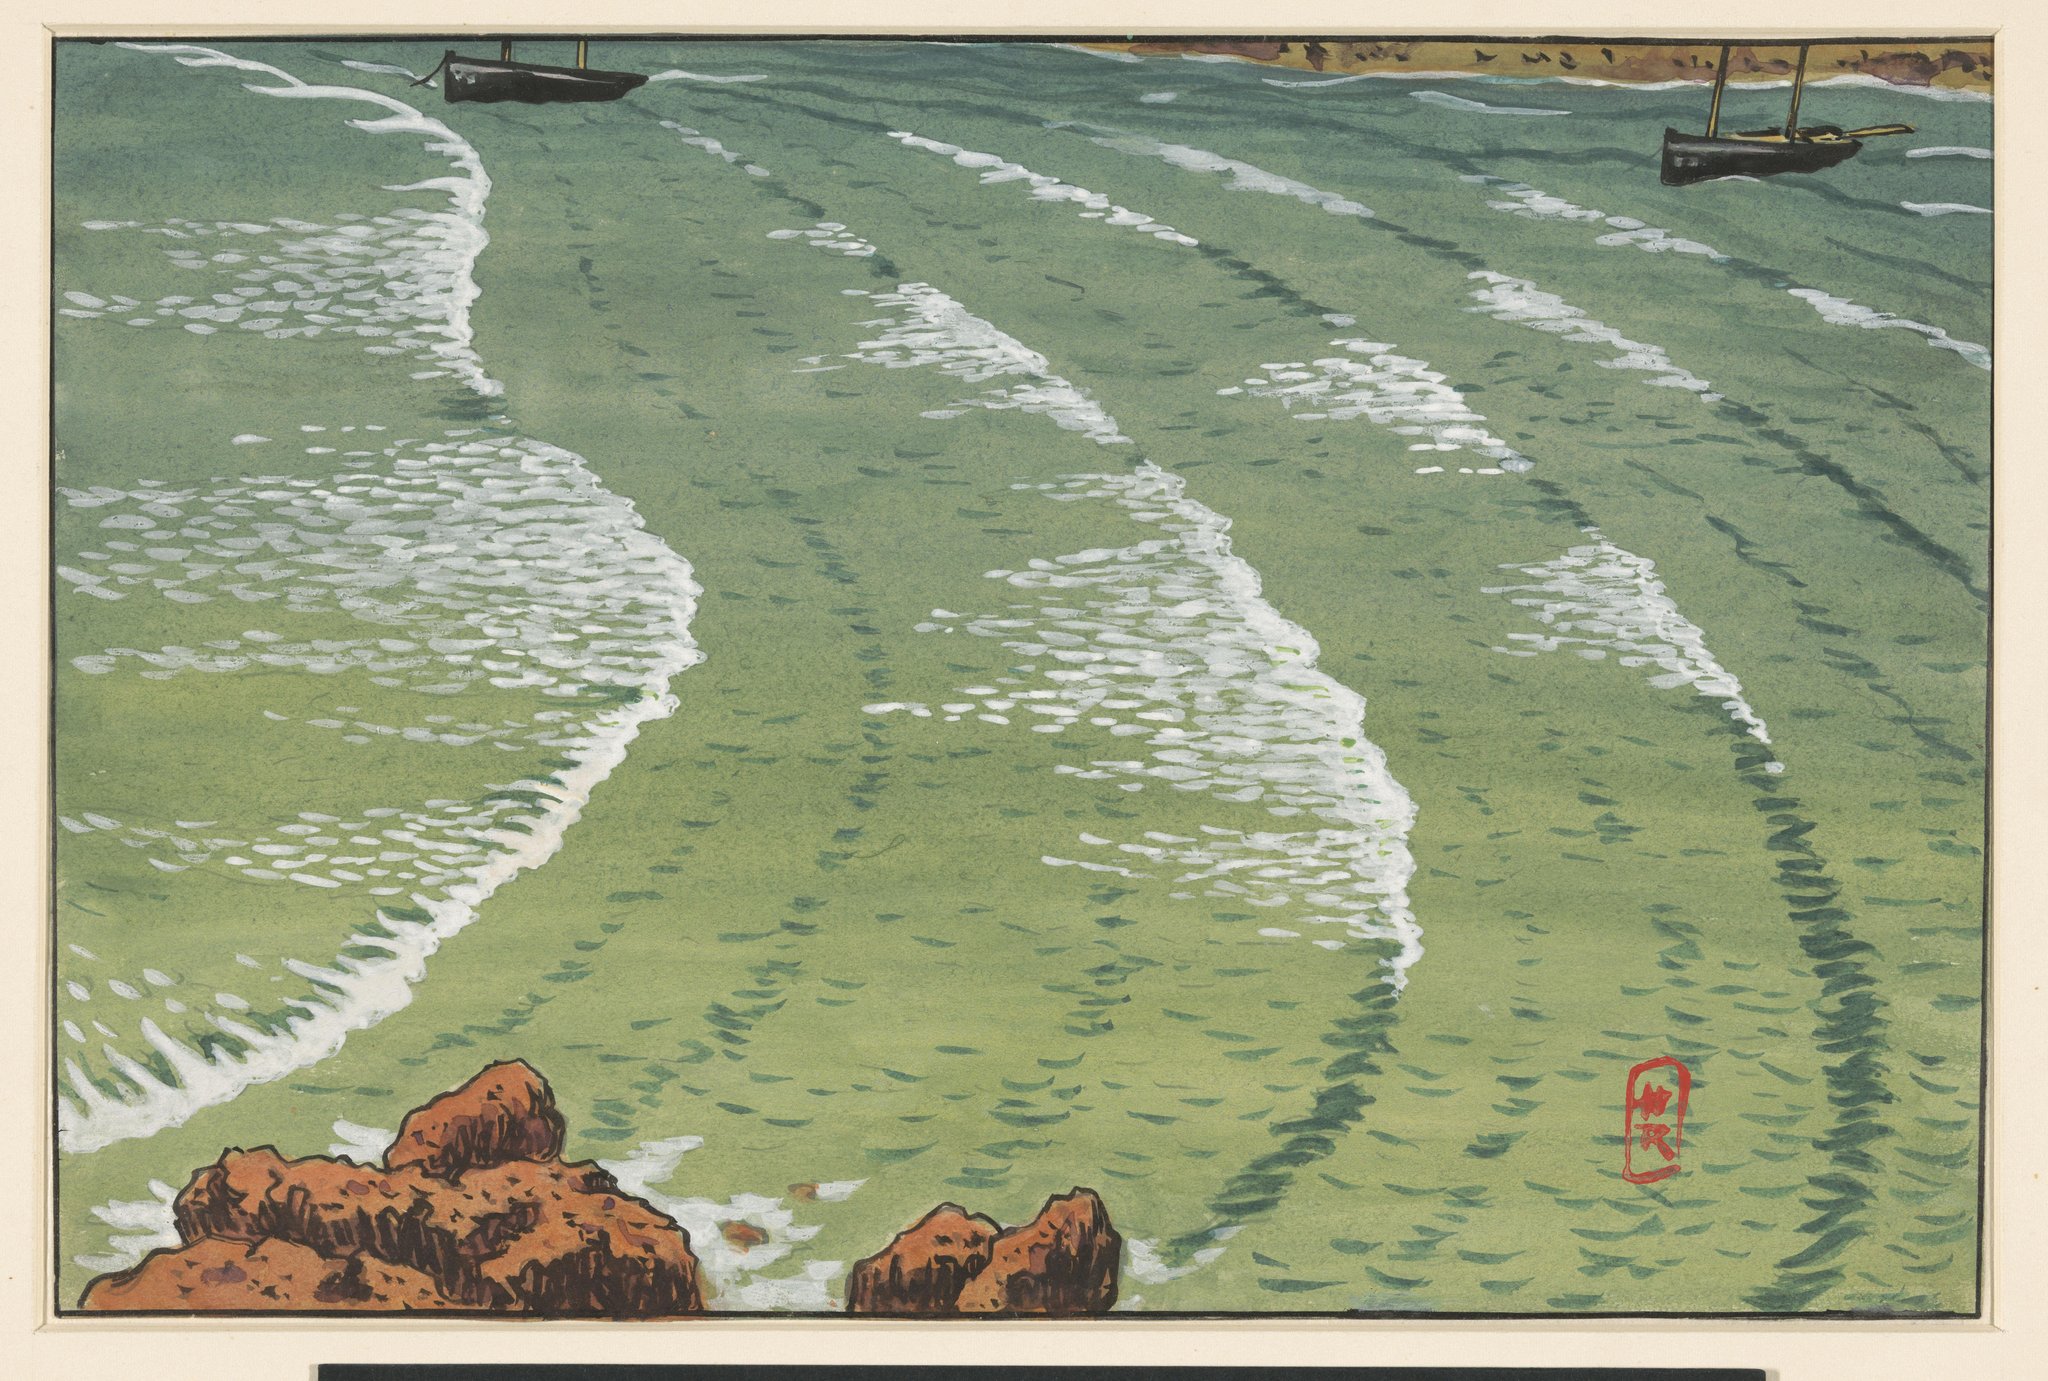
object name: drawing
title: Zee, in een baai, met schepen voor de rotsige kust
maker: henri rivière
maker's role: draughtsman, print maker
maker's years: 1864-1951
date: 1874-1920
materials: paint, paper, watercolor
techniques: brush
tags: rocky coast